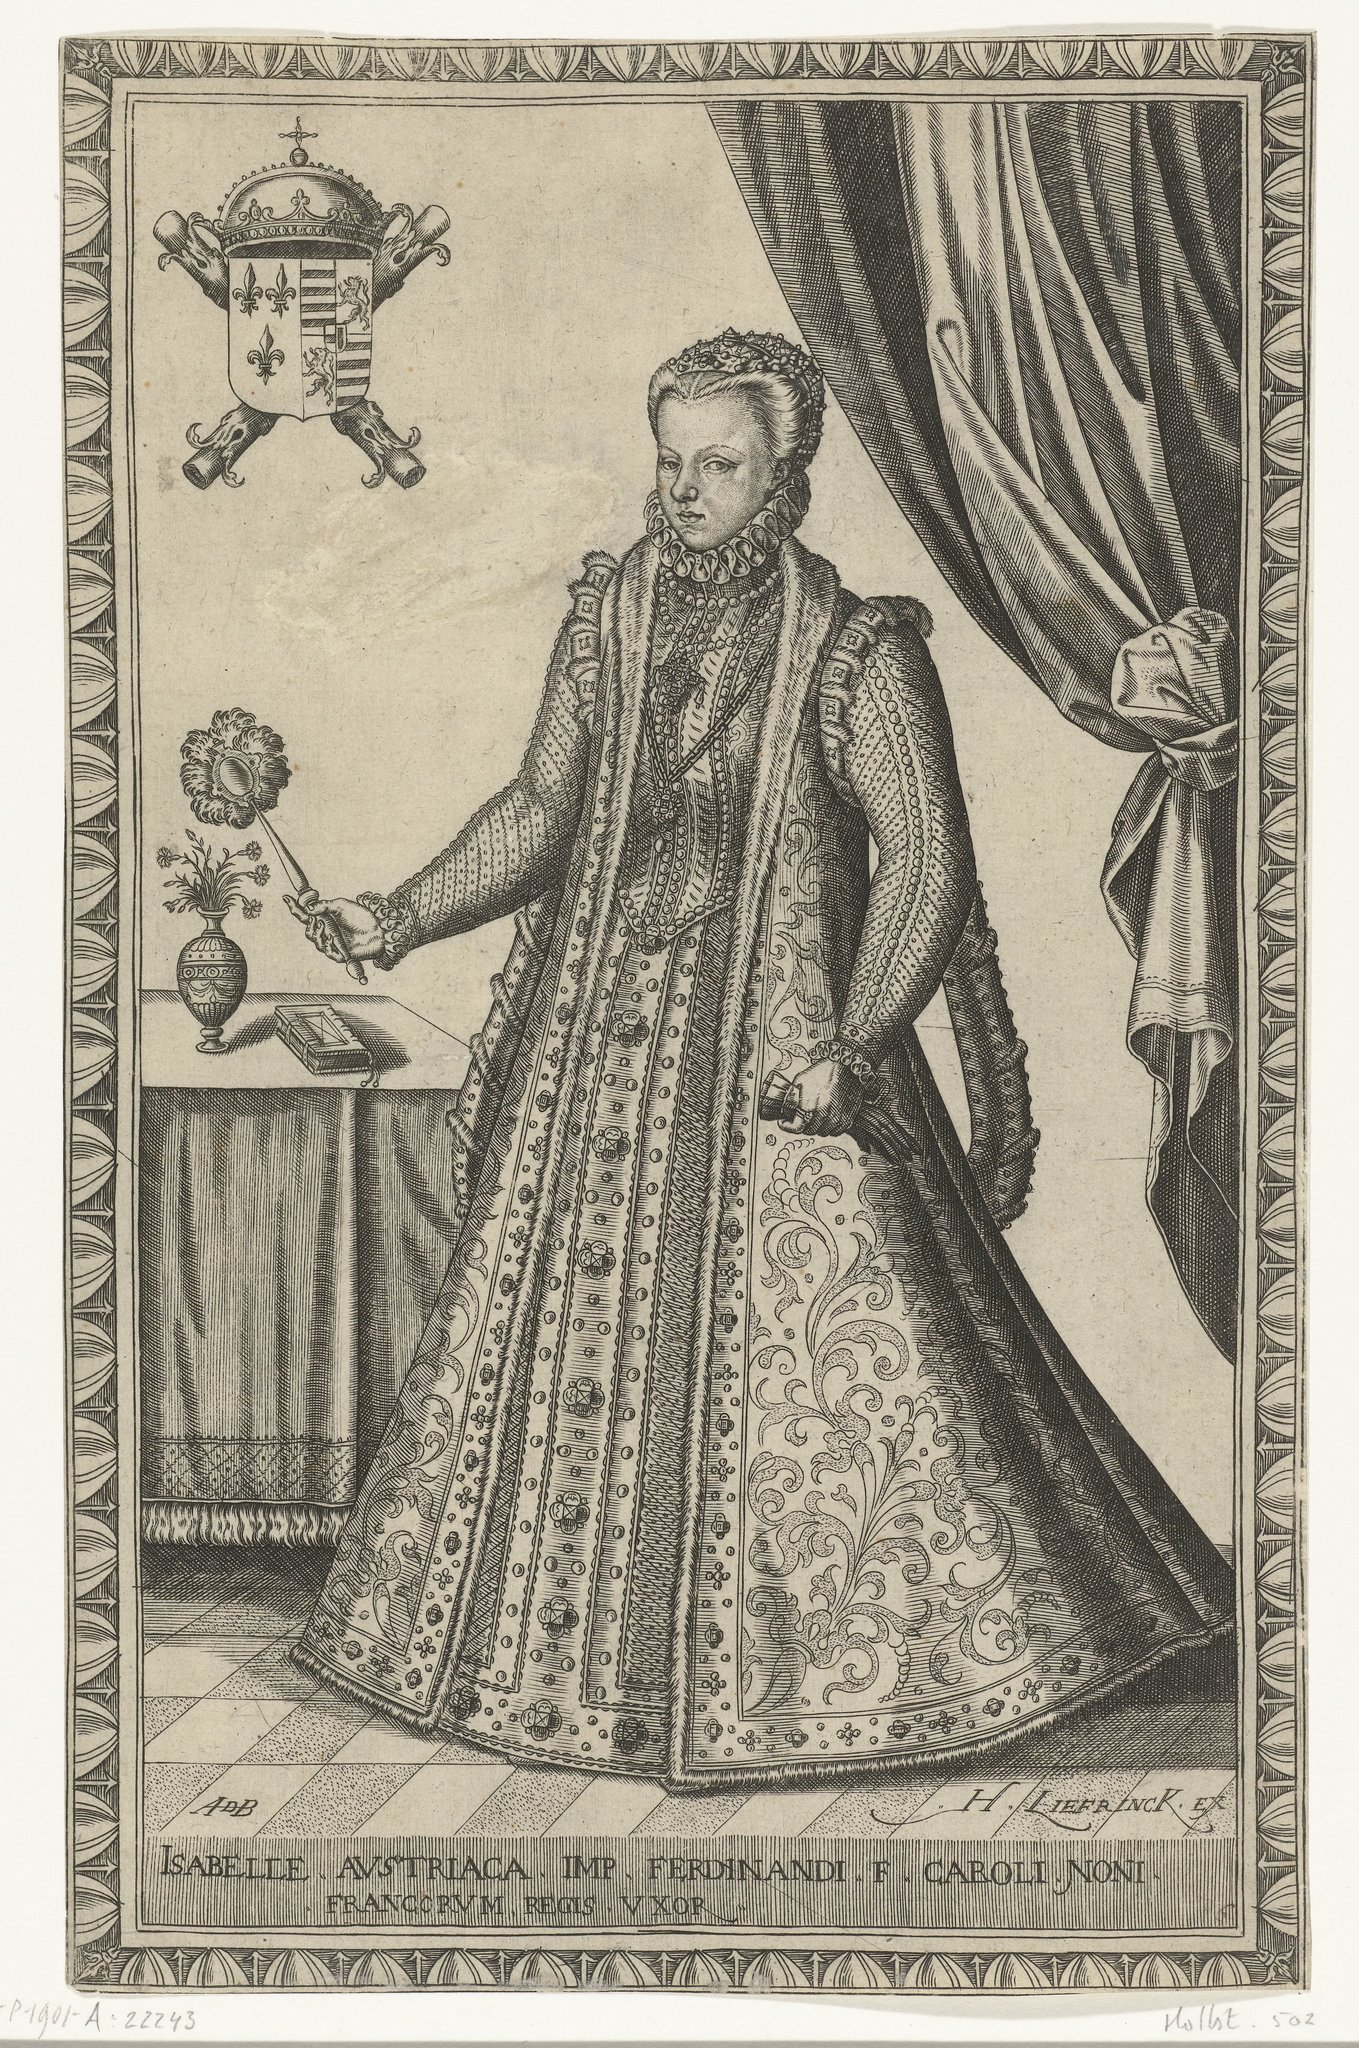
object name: print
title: Portret van Elisabeth van Oostenrijk, gemalin van Karel IX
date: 1570-1574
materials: paper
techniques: engraving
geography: antwerp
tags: vienna, historical persons, neck-gear ~ clothing (with name) (+ women's clothes), gloves, mittens, etc. (+ women's clothes), dress, gown (+ women's clothes), fan, sleeves (+ women's clothes), necklace (+ women's clothes), attributes of dignitary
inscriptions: collector's mark: Lugt 2228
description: Ze is gekleed in een vlieger* met siermouwen*, afgezet met bont, Hieronder een hoge geplooide kraag* en kleine geplooide manchetten* aan de mouwen. In haar rechterhand een veren waaier*, in de linkerhand een handschoen*. Op het hoofd een fantasiemutsje met parels. Om de hals verschillende kettingen* en een hanger*.